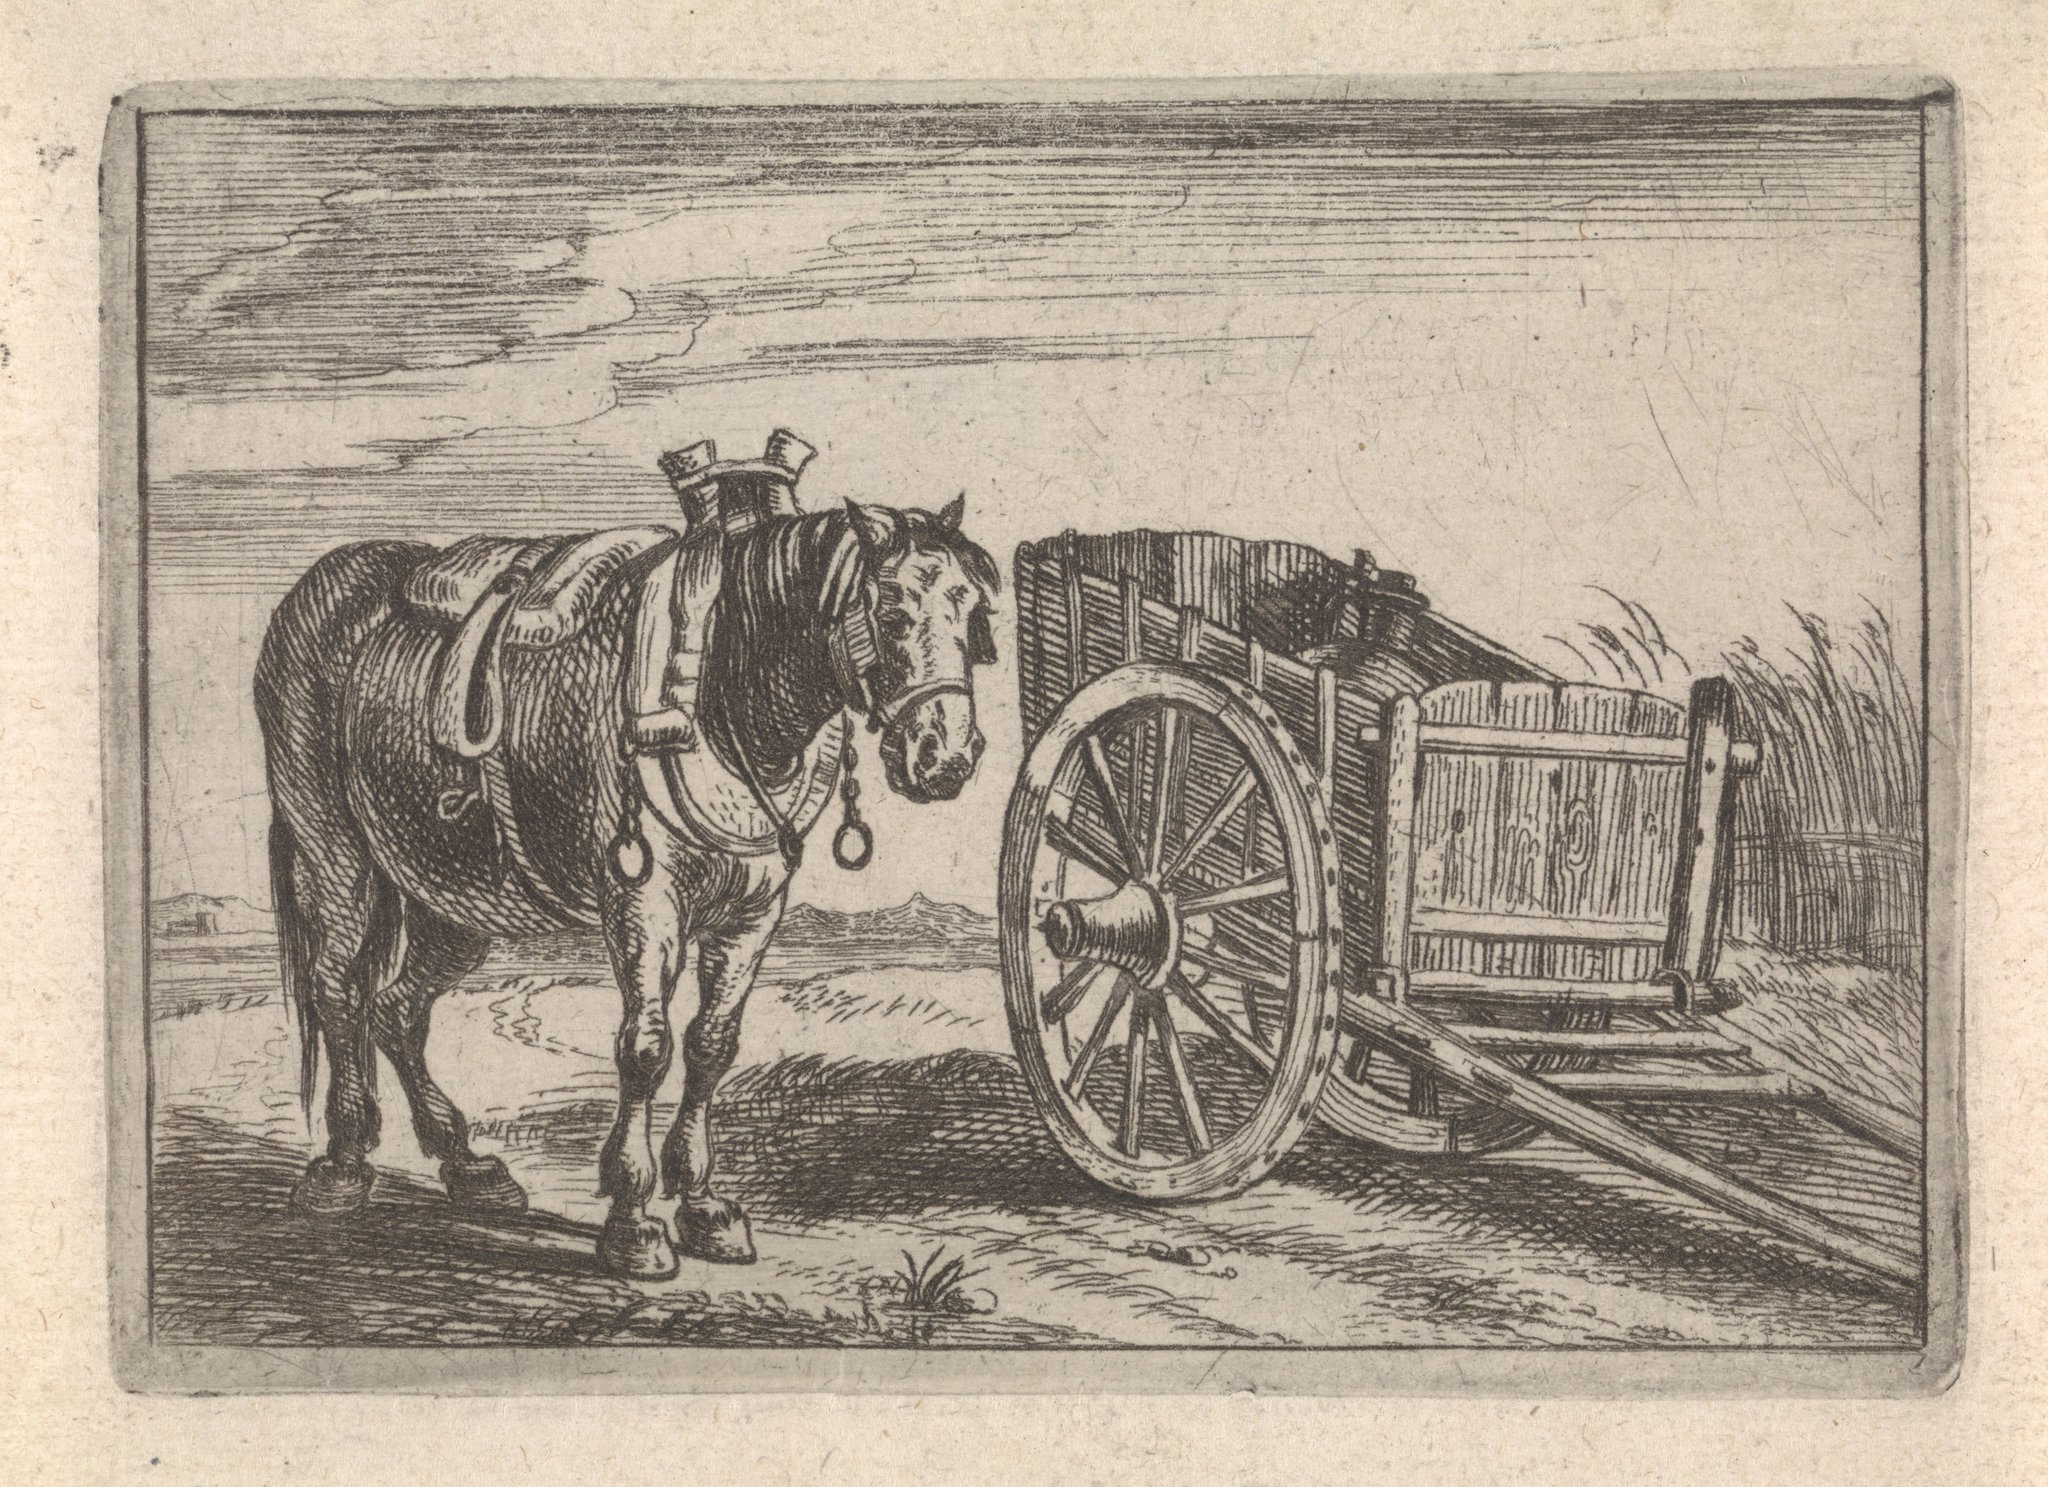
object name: print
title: Opgetuigd paard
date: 1654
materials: paper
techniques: etching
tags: two-wheeled, animal-drawn vehicle, horse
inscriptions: collector's mark: Lugt 2228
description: Landschap met een opgetuigd paard naast een kar met twee wielen. Deze prent maakt deel uit van een tiendelige serie over diverse dieren.